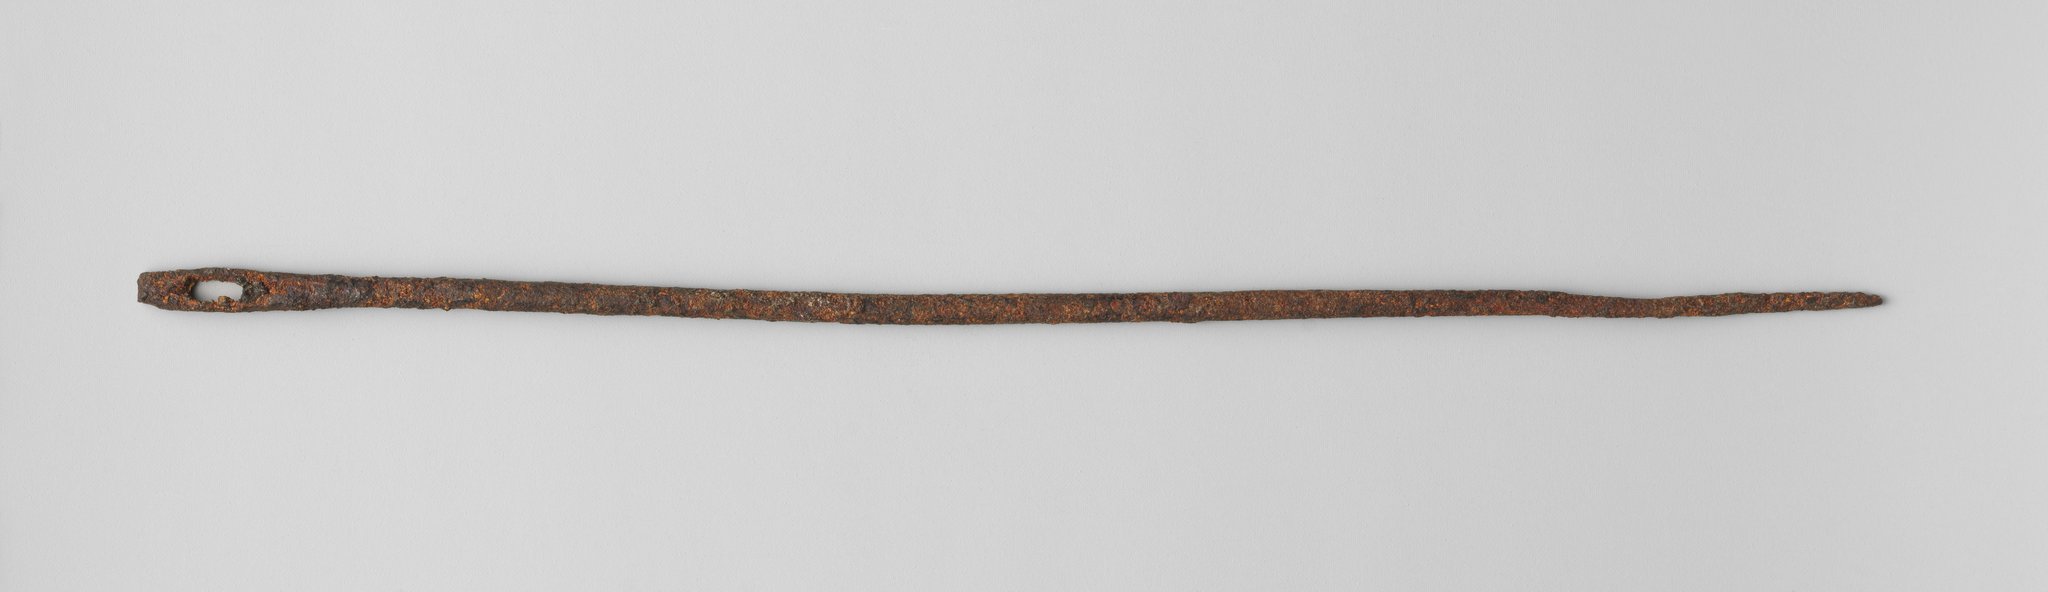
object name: needle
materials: copper alloy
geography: egypt